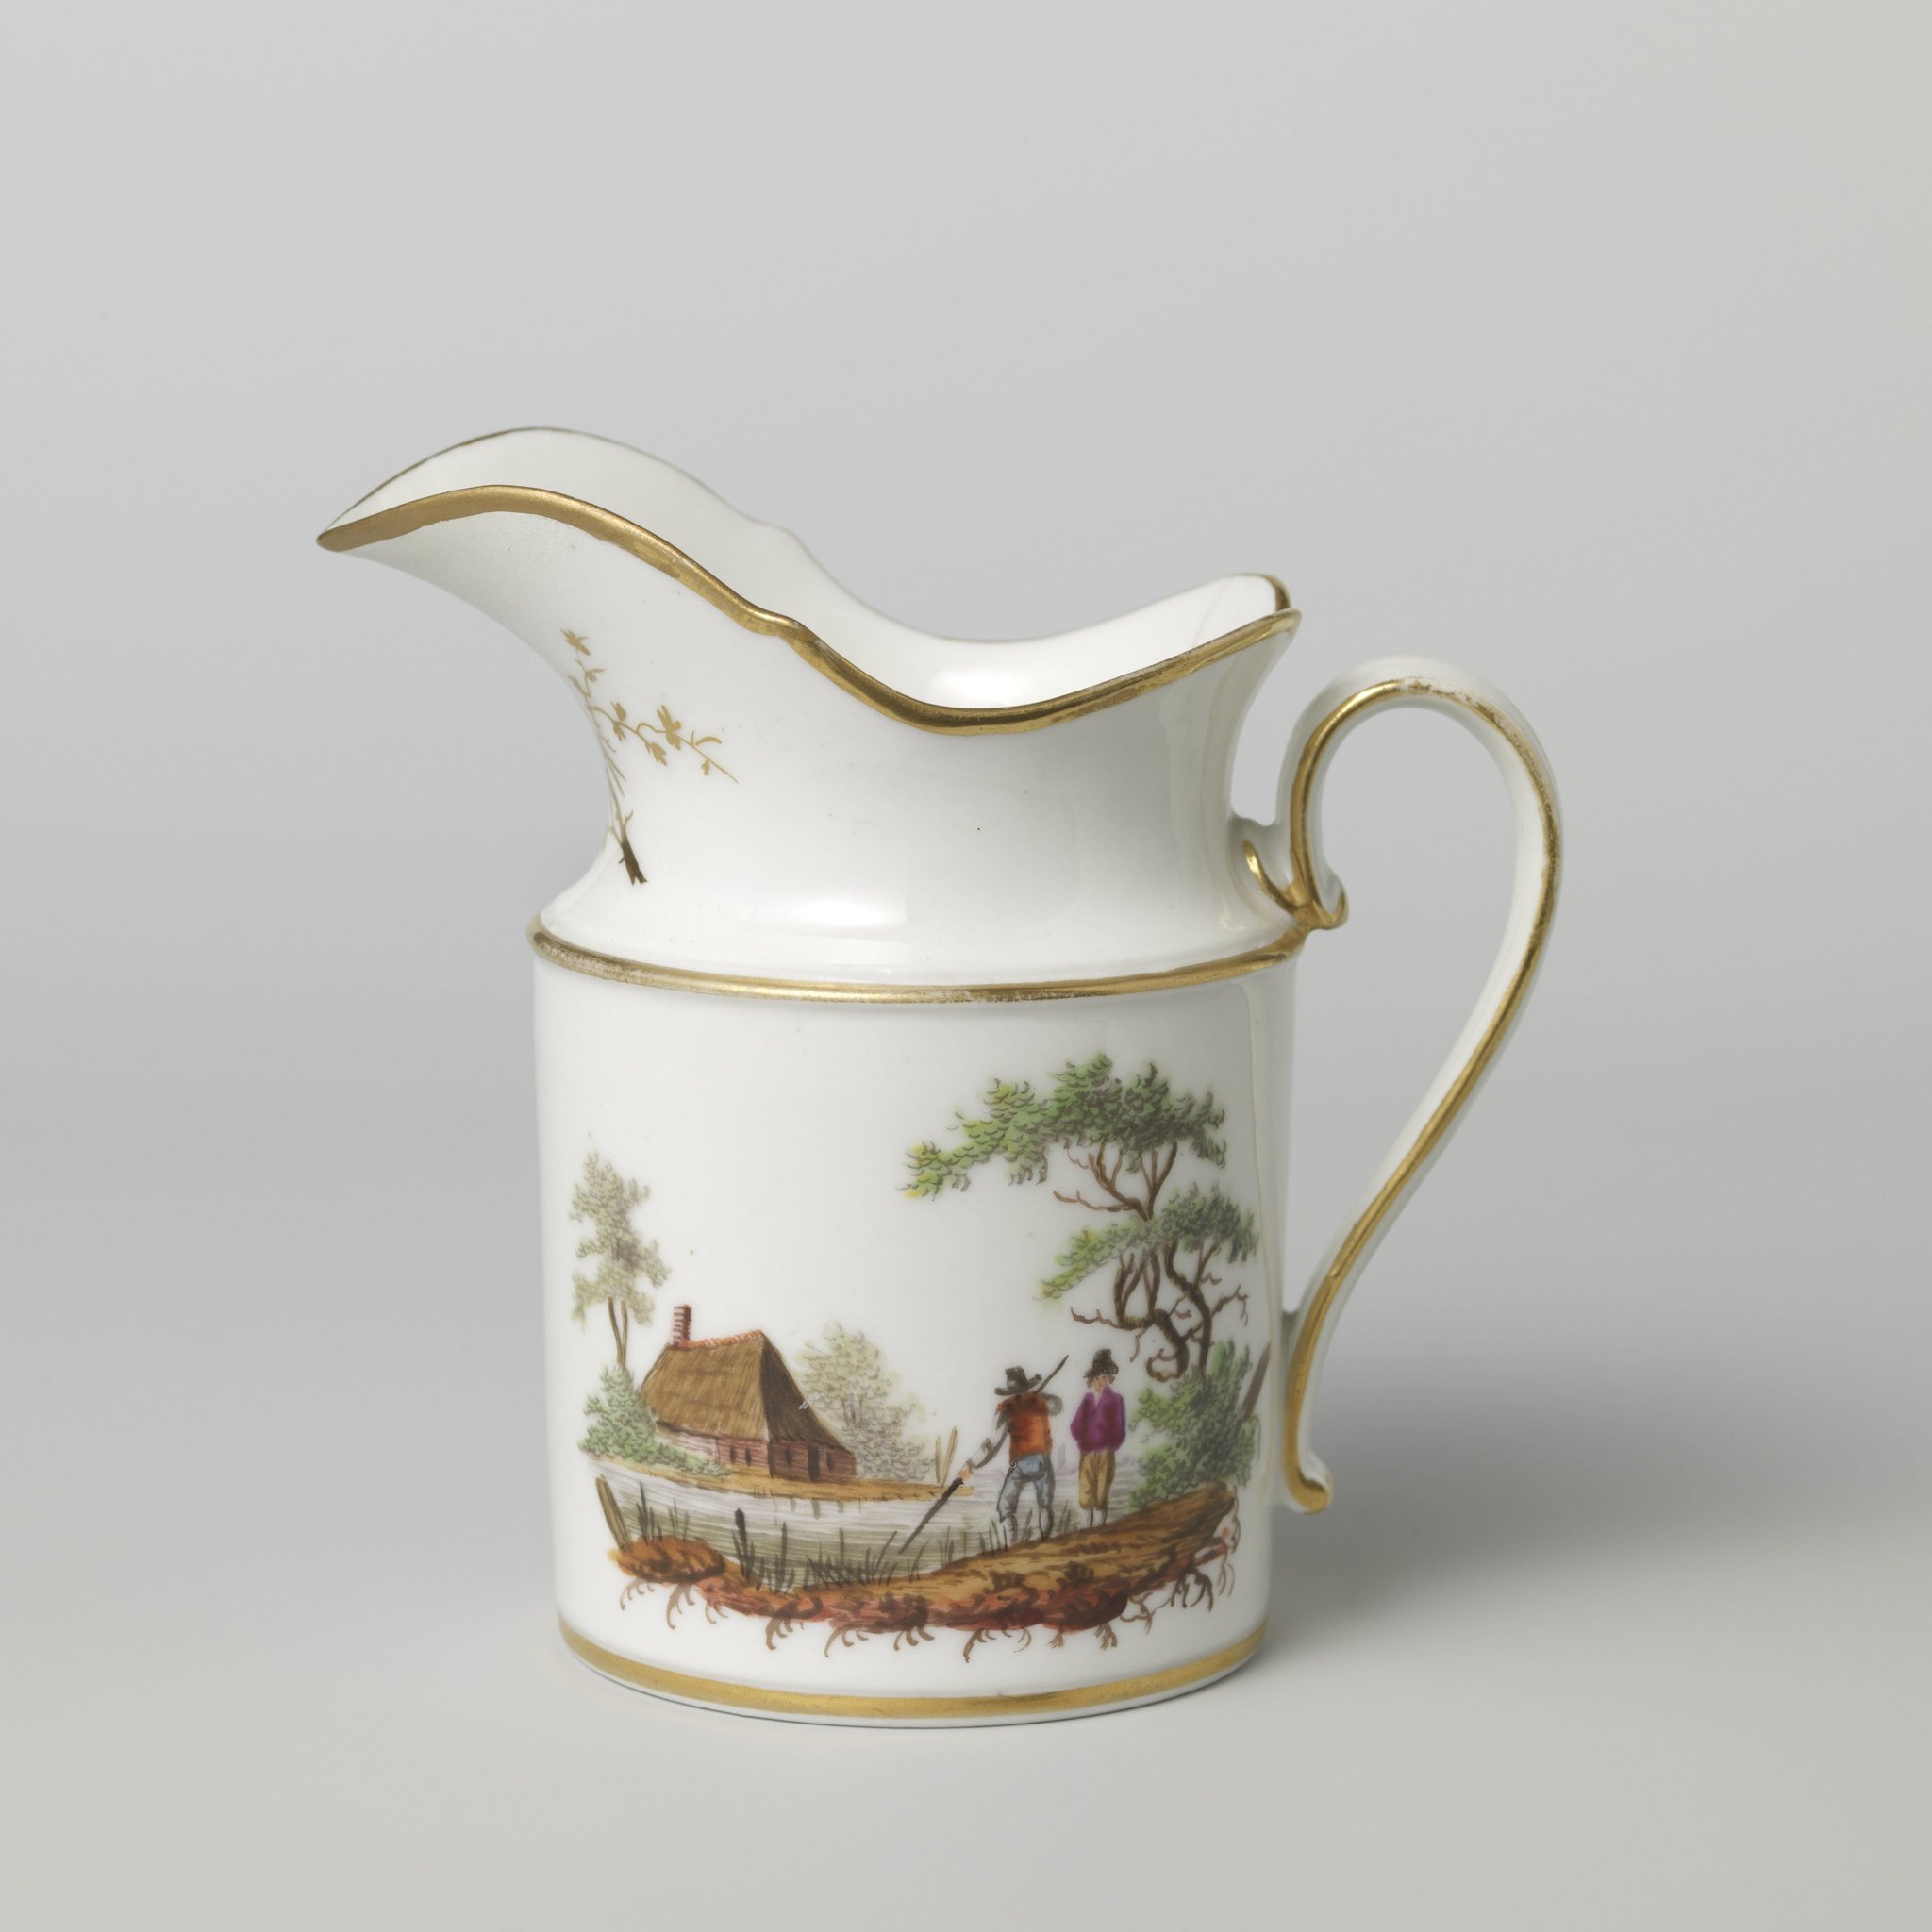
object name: milk jug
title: Melkkan, beschilderd met een landschap met huizen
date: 1809-1814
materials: porcelain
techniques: painted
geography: nieuwer-amstel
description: Melkkan van porselein, beschilderd met een landschap met huizen. Gemerkt in zwart: Amstel. De melkkan is defect.